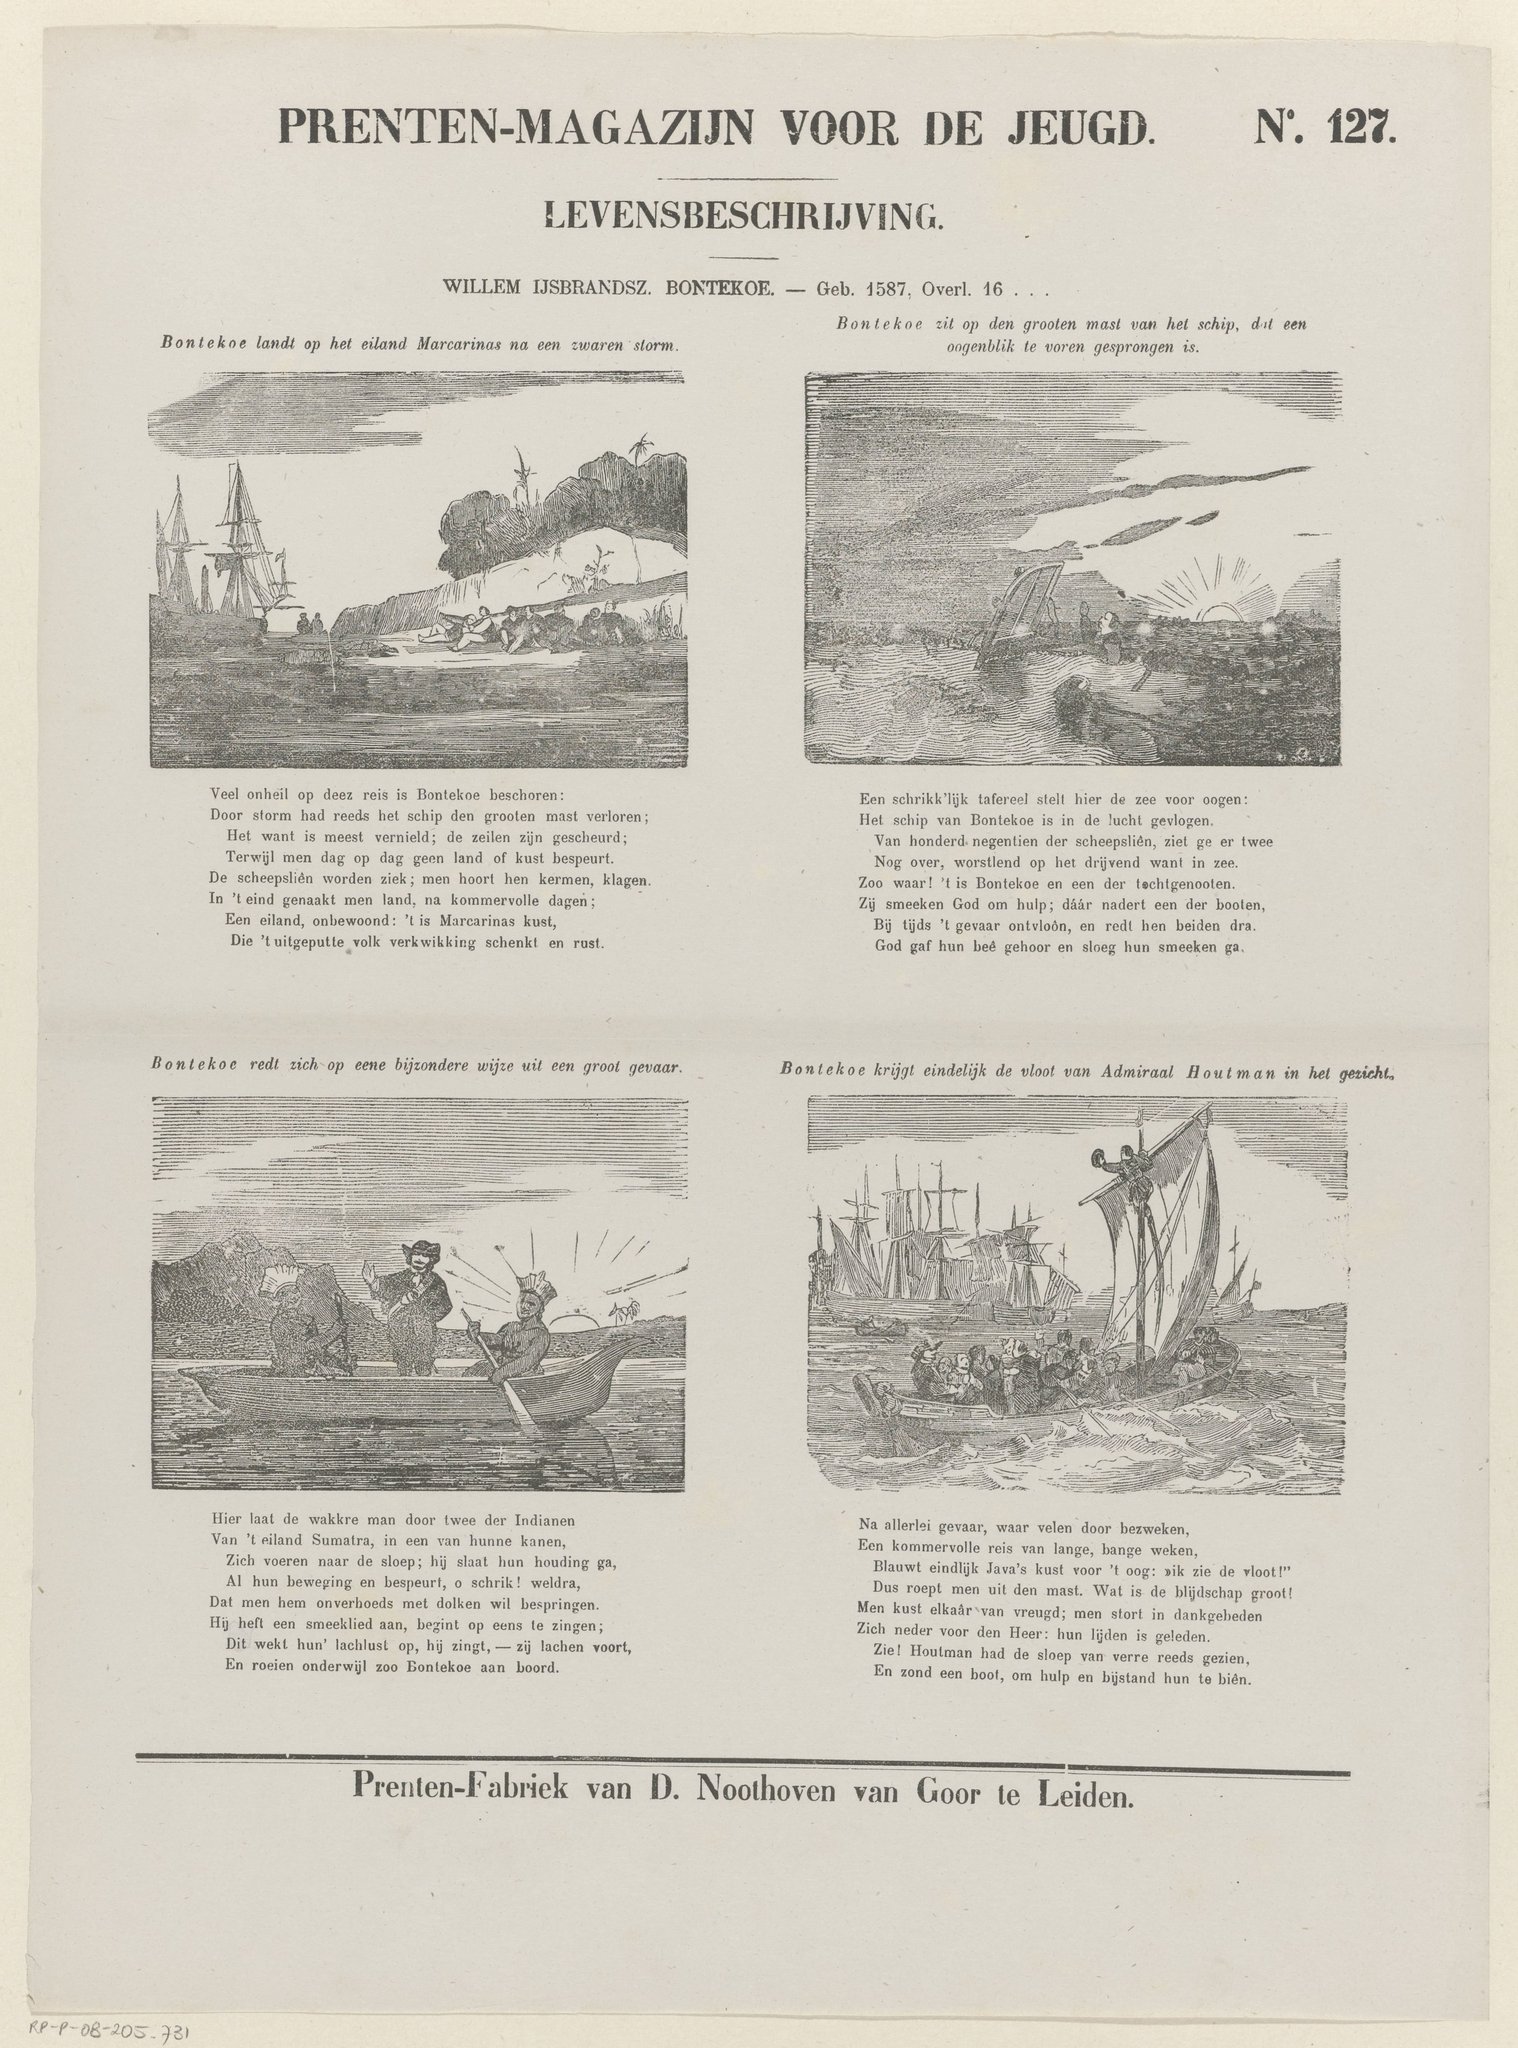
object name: print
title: Levensbeschrijving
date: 1850-1881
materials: paper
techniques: letterpress printing, engraving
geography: netherlands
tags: willem ysbrantsz. bontekoe, historical persons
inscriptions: collector's mark: Lugt 2760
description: Blad met 4 voorstellingen uit het leven van Willem Ysbrantsz. Bontekoe. Boven elke afbeelding een titel, onder elke afbeelding een achtregelig vers. Genummerd rechtsboven: No. 127.